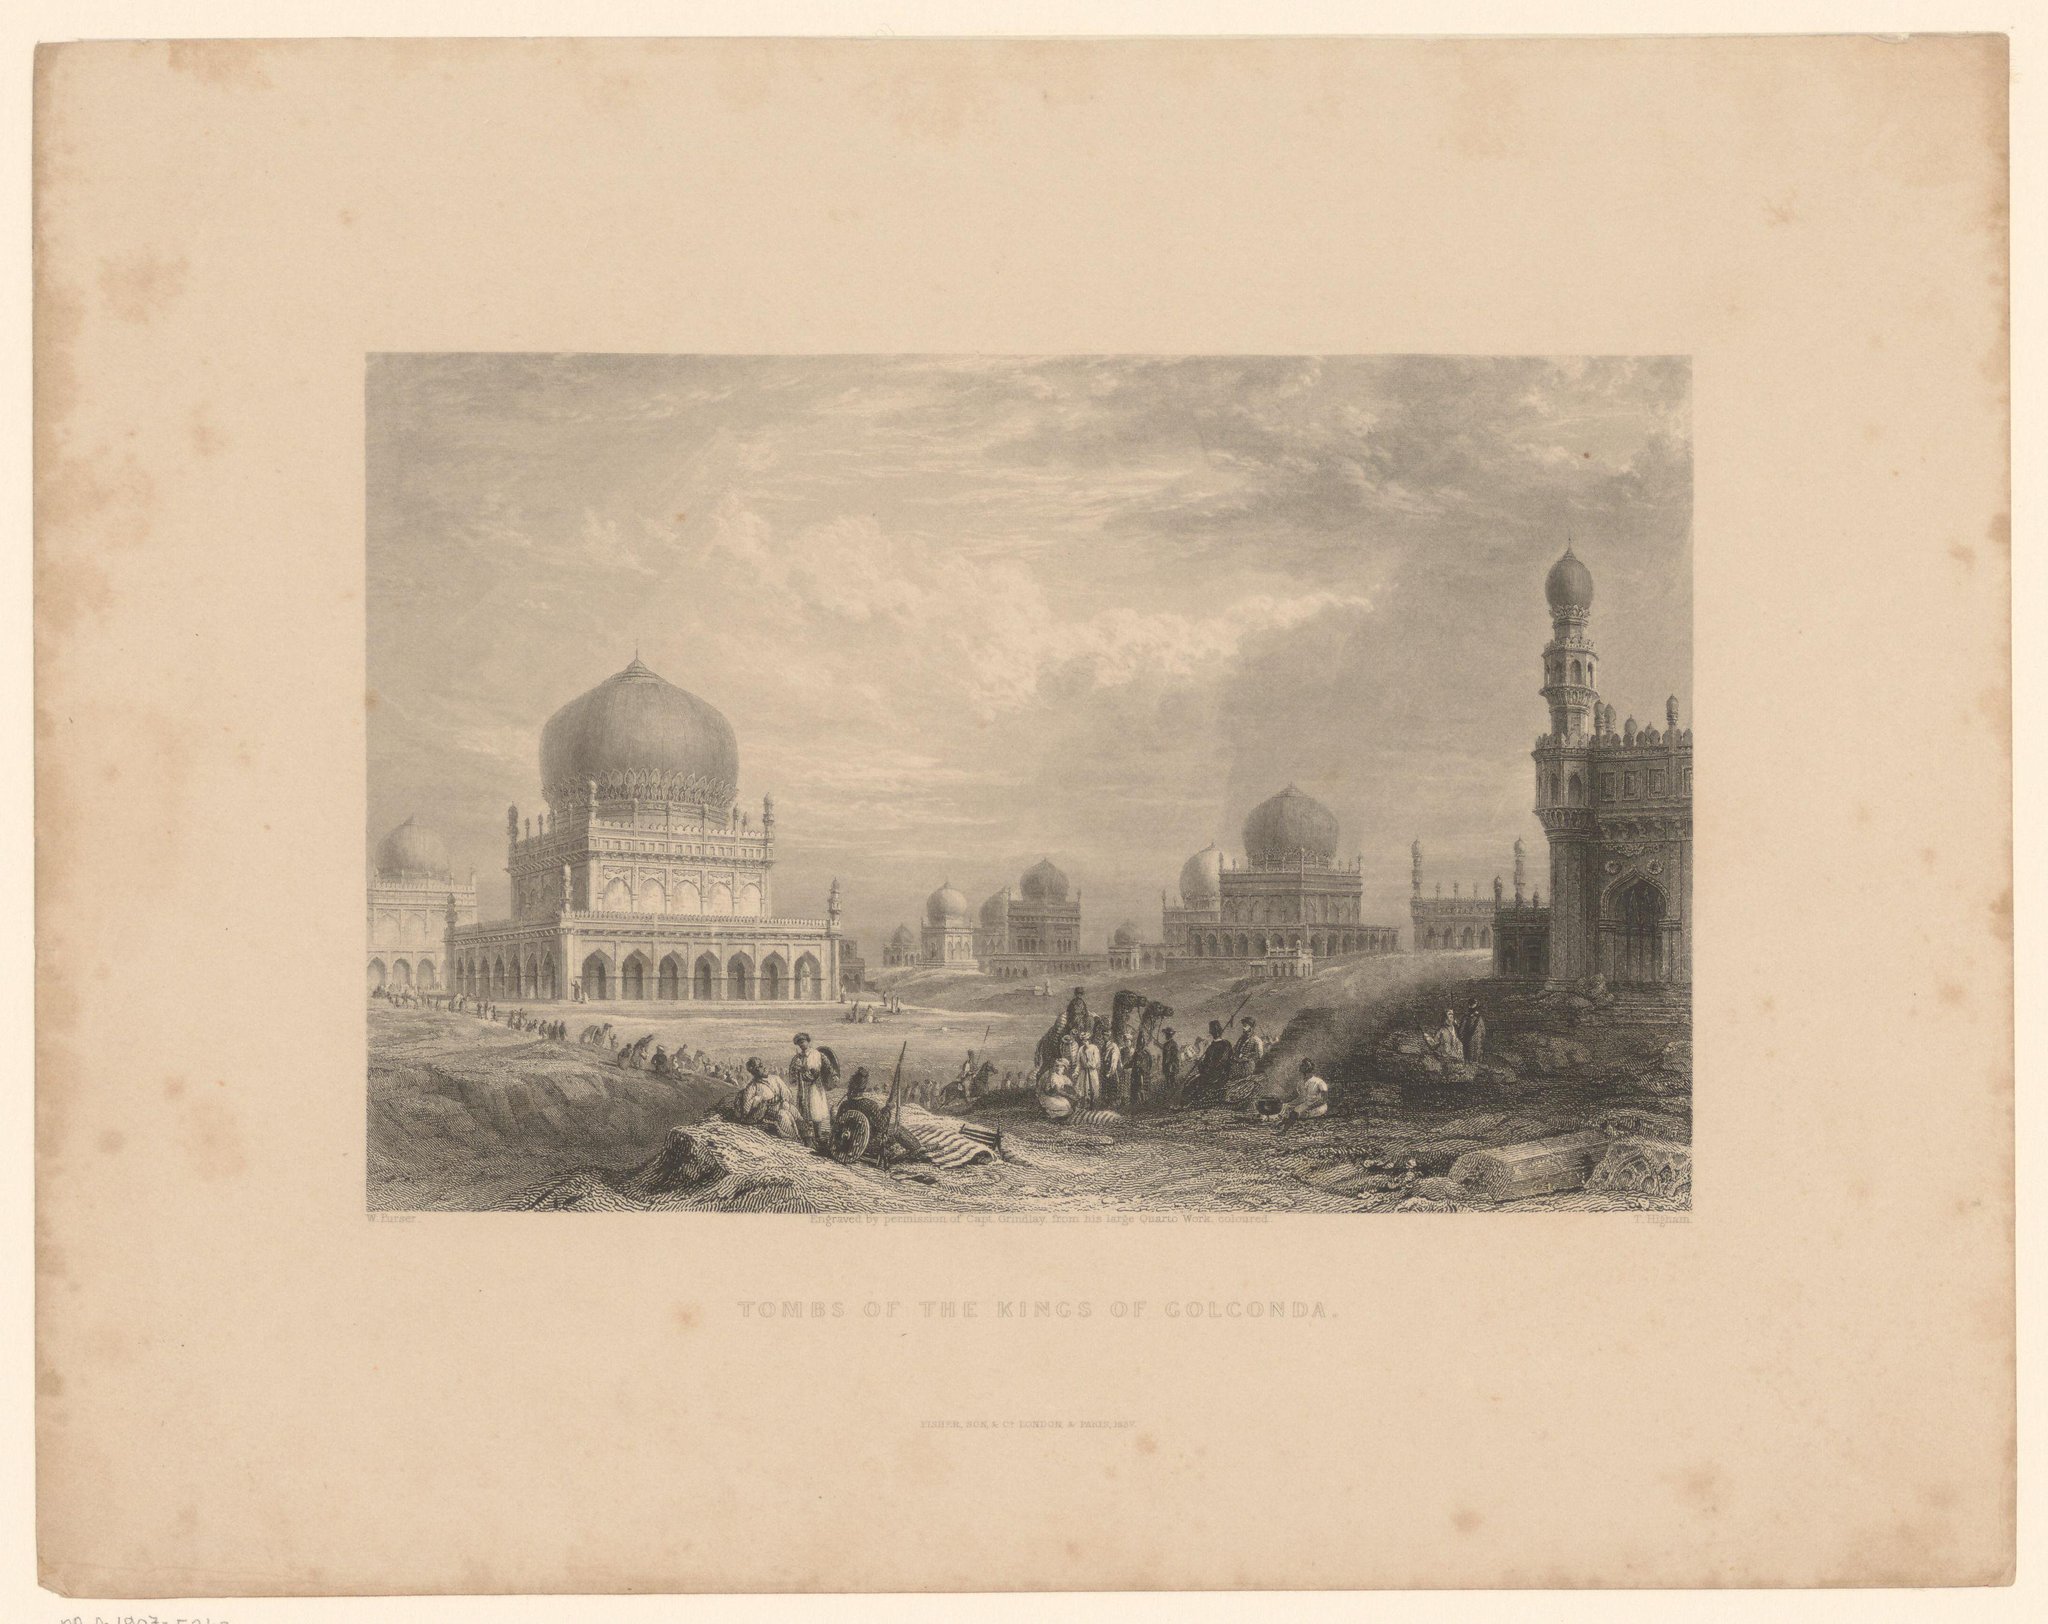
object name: print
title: Gezicht op de Qutb Shahi tombes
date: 1837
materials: paper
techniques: engraving, etching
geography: london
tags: grave, tomb, temple, shrine ~ islam, mohammedanism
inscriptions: collector's mark: Lugt 2228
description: Prent is gemaakt met toestemming van Robert Melville Grindlay, die tussen 1826 en 1830 'Scenery, Costumes and Architecture, chiefly on the Western Side of India', uitgaf met daarin een boekillustratie waarop deze prent is gebaseerd.